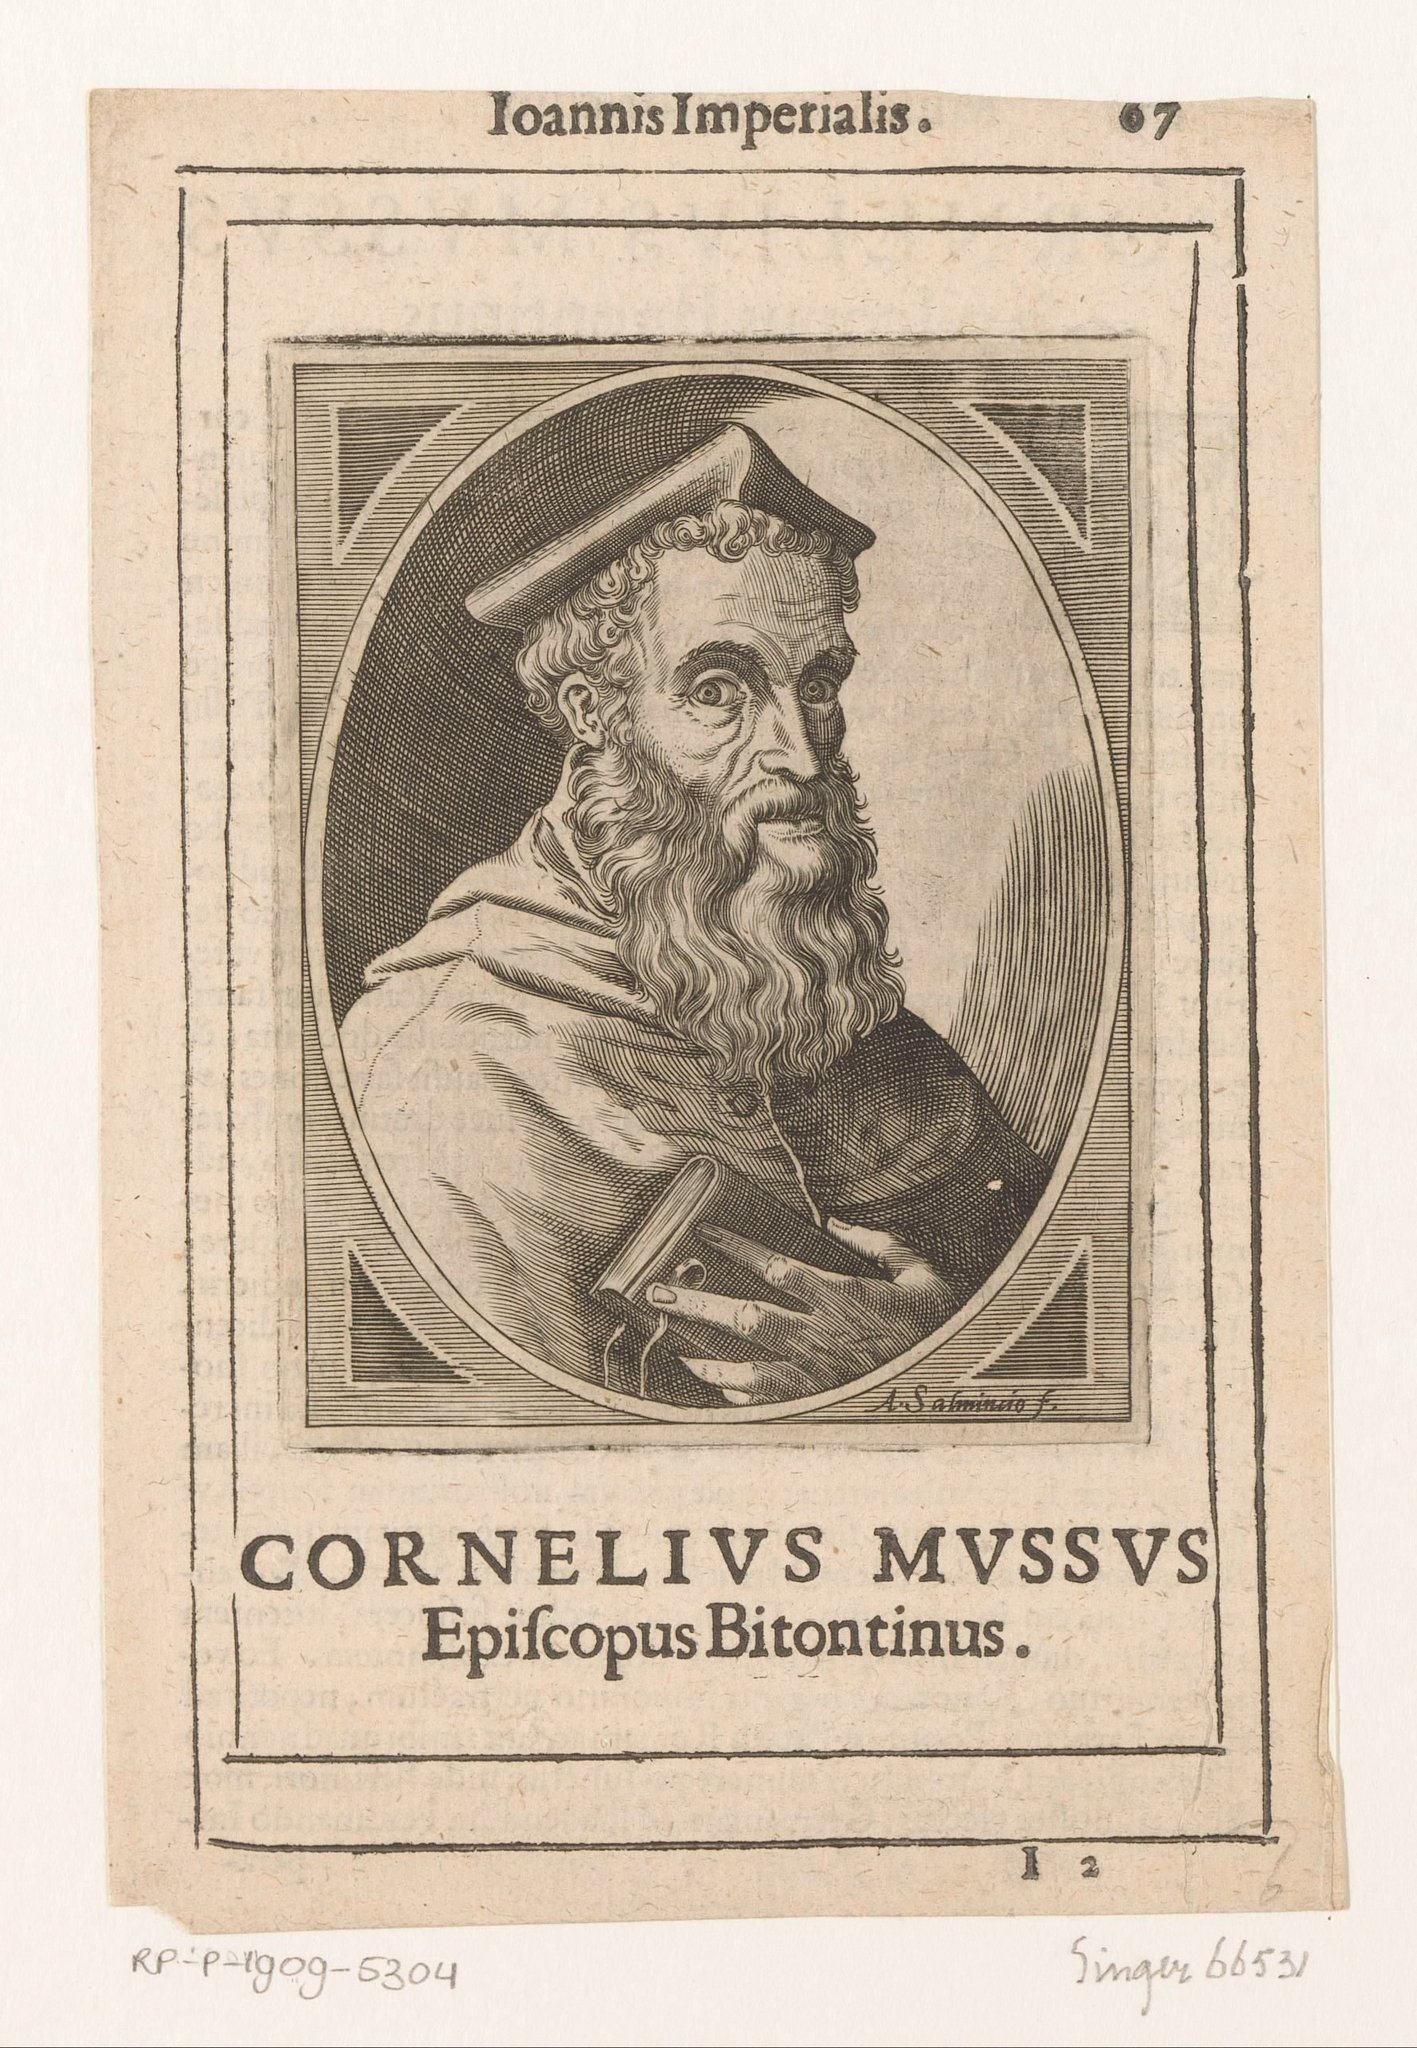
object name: print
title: Portret van filosoof Jacopo Mazzoni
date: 1640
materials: paper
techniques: engraving, letterpress printing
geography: venice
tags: historical persons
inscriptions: collector's mark: Lugt 2228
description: Prent uit: Imperiali, Giovanni. Musaeum historicum et physicum ... In primo illustrium literis virorum imagines ad vivum expressȩ continentur, additis elogiis ... In secundo animorum imagines, sive ingeniorum naturȩ, differentiȩ, causȩ, ac signa physice perpenduntur .... Venetië: Apud Juntas, 1640.